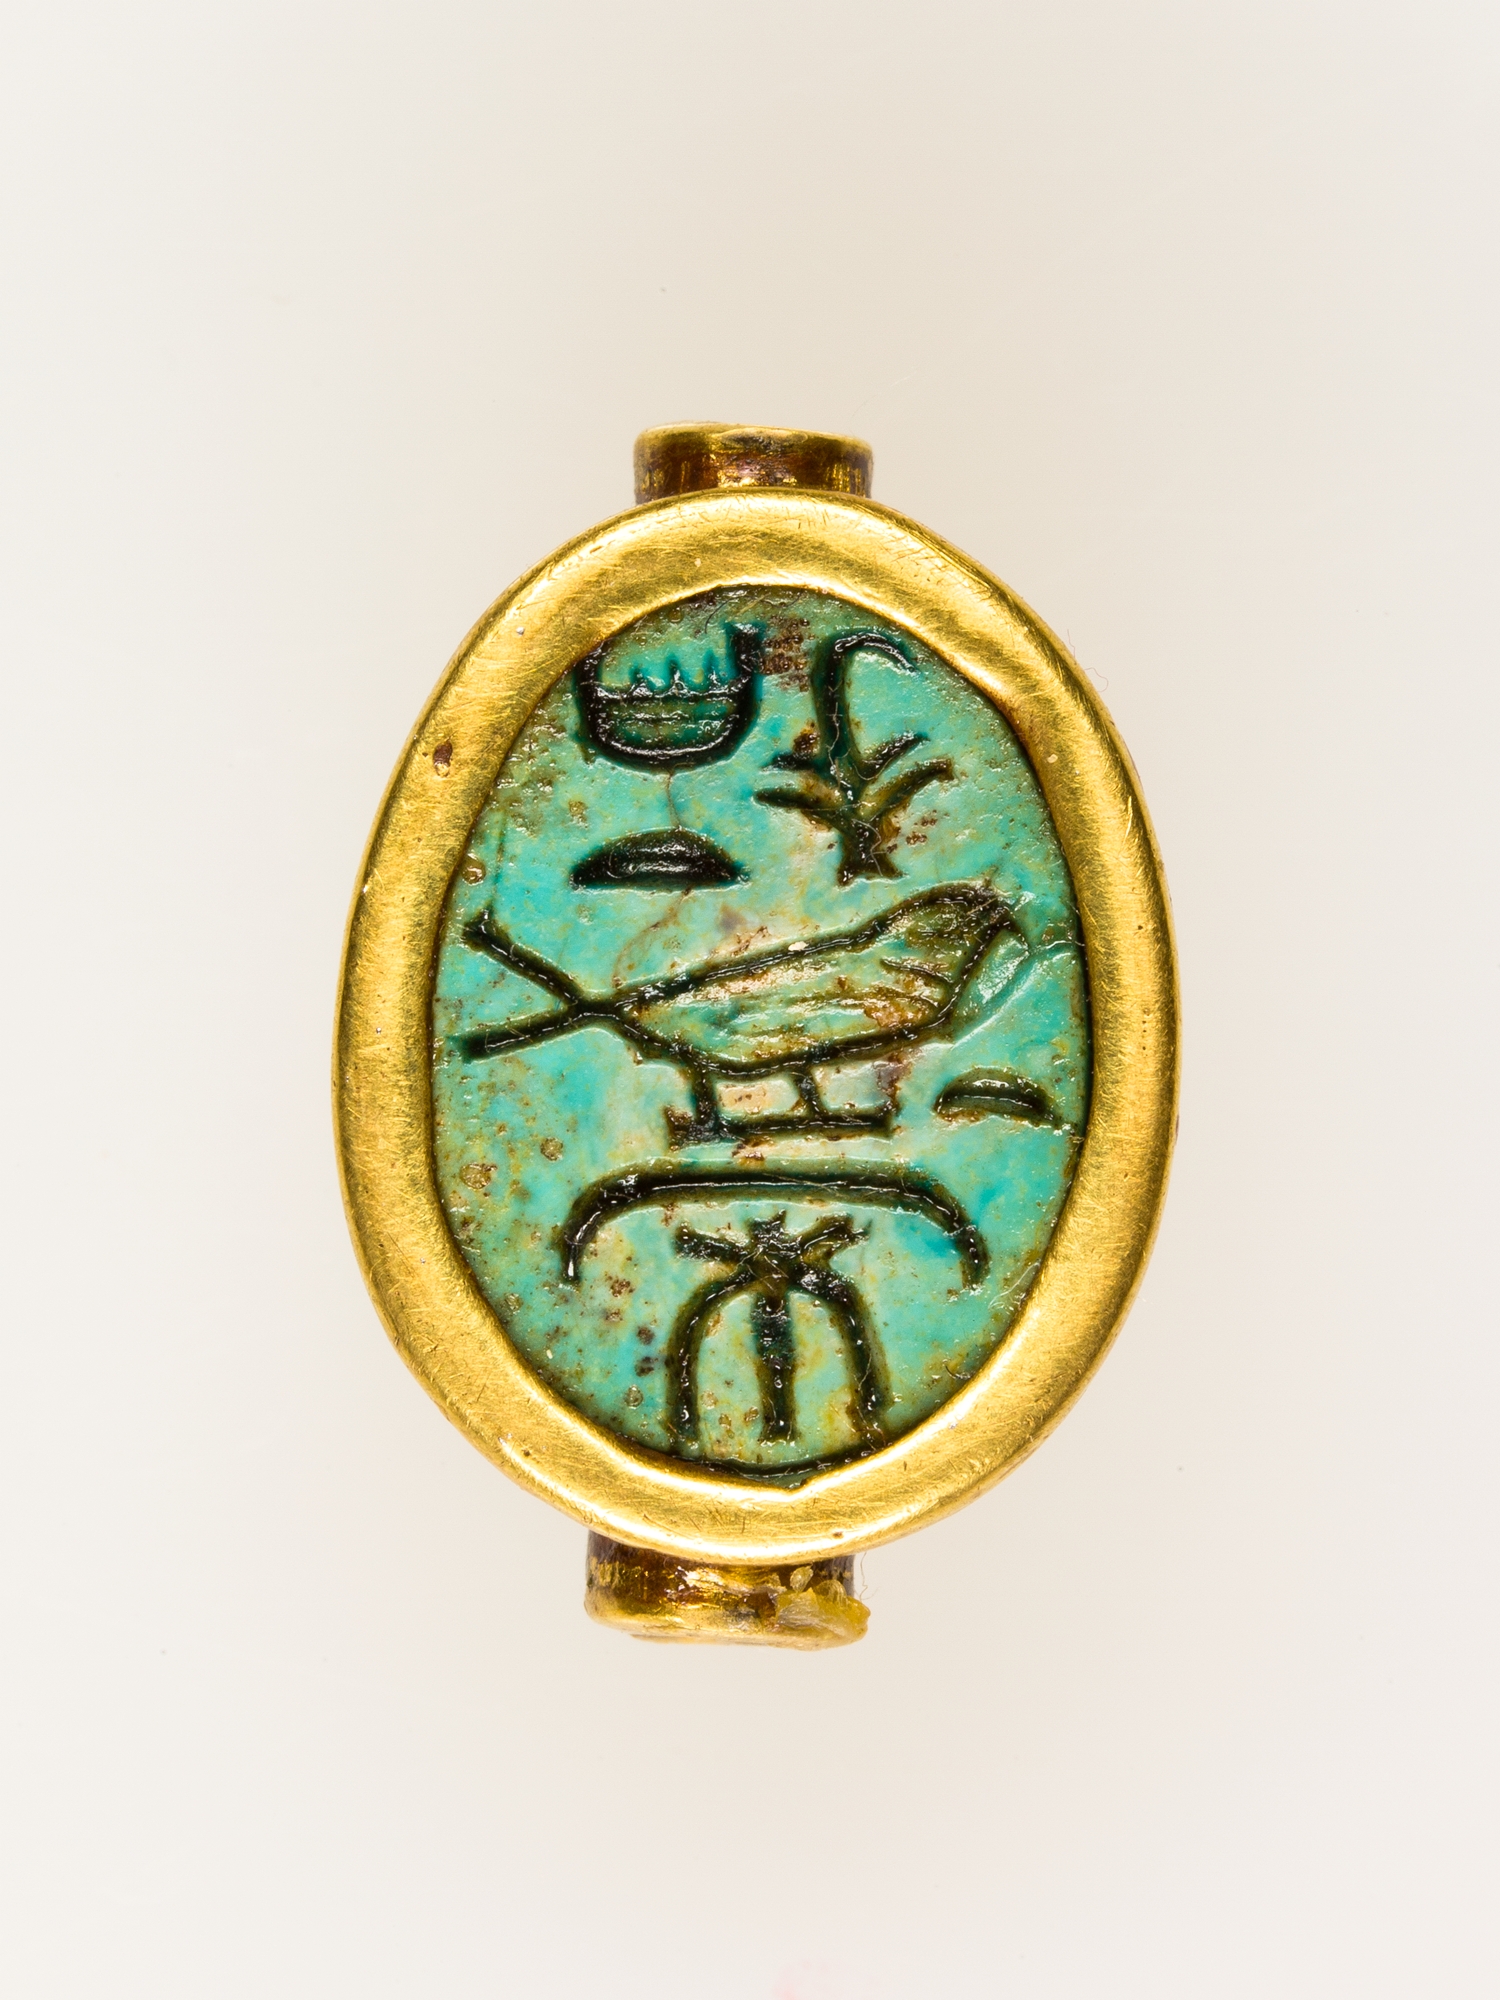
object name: scarab, ahmose nefertari, principal queen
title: Scarab of Queen Ahmose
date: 1550-1475 BCE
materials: faience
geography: egypt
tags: hieroglyphs,scarabs